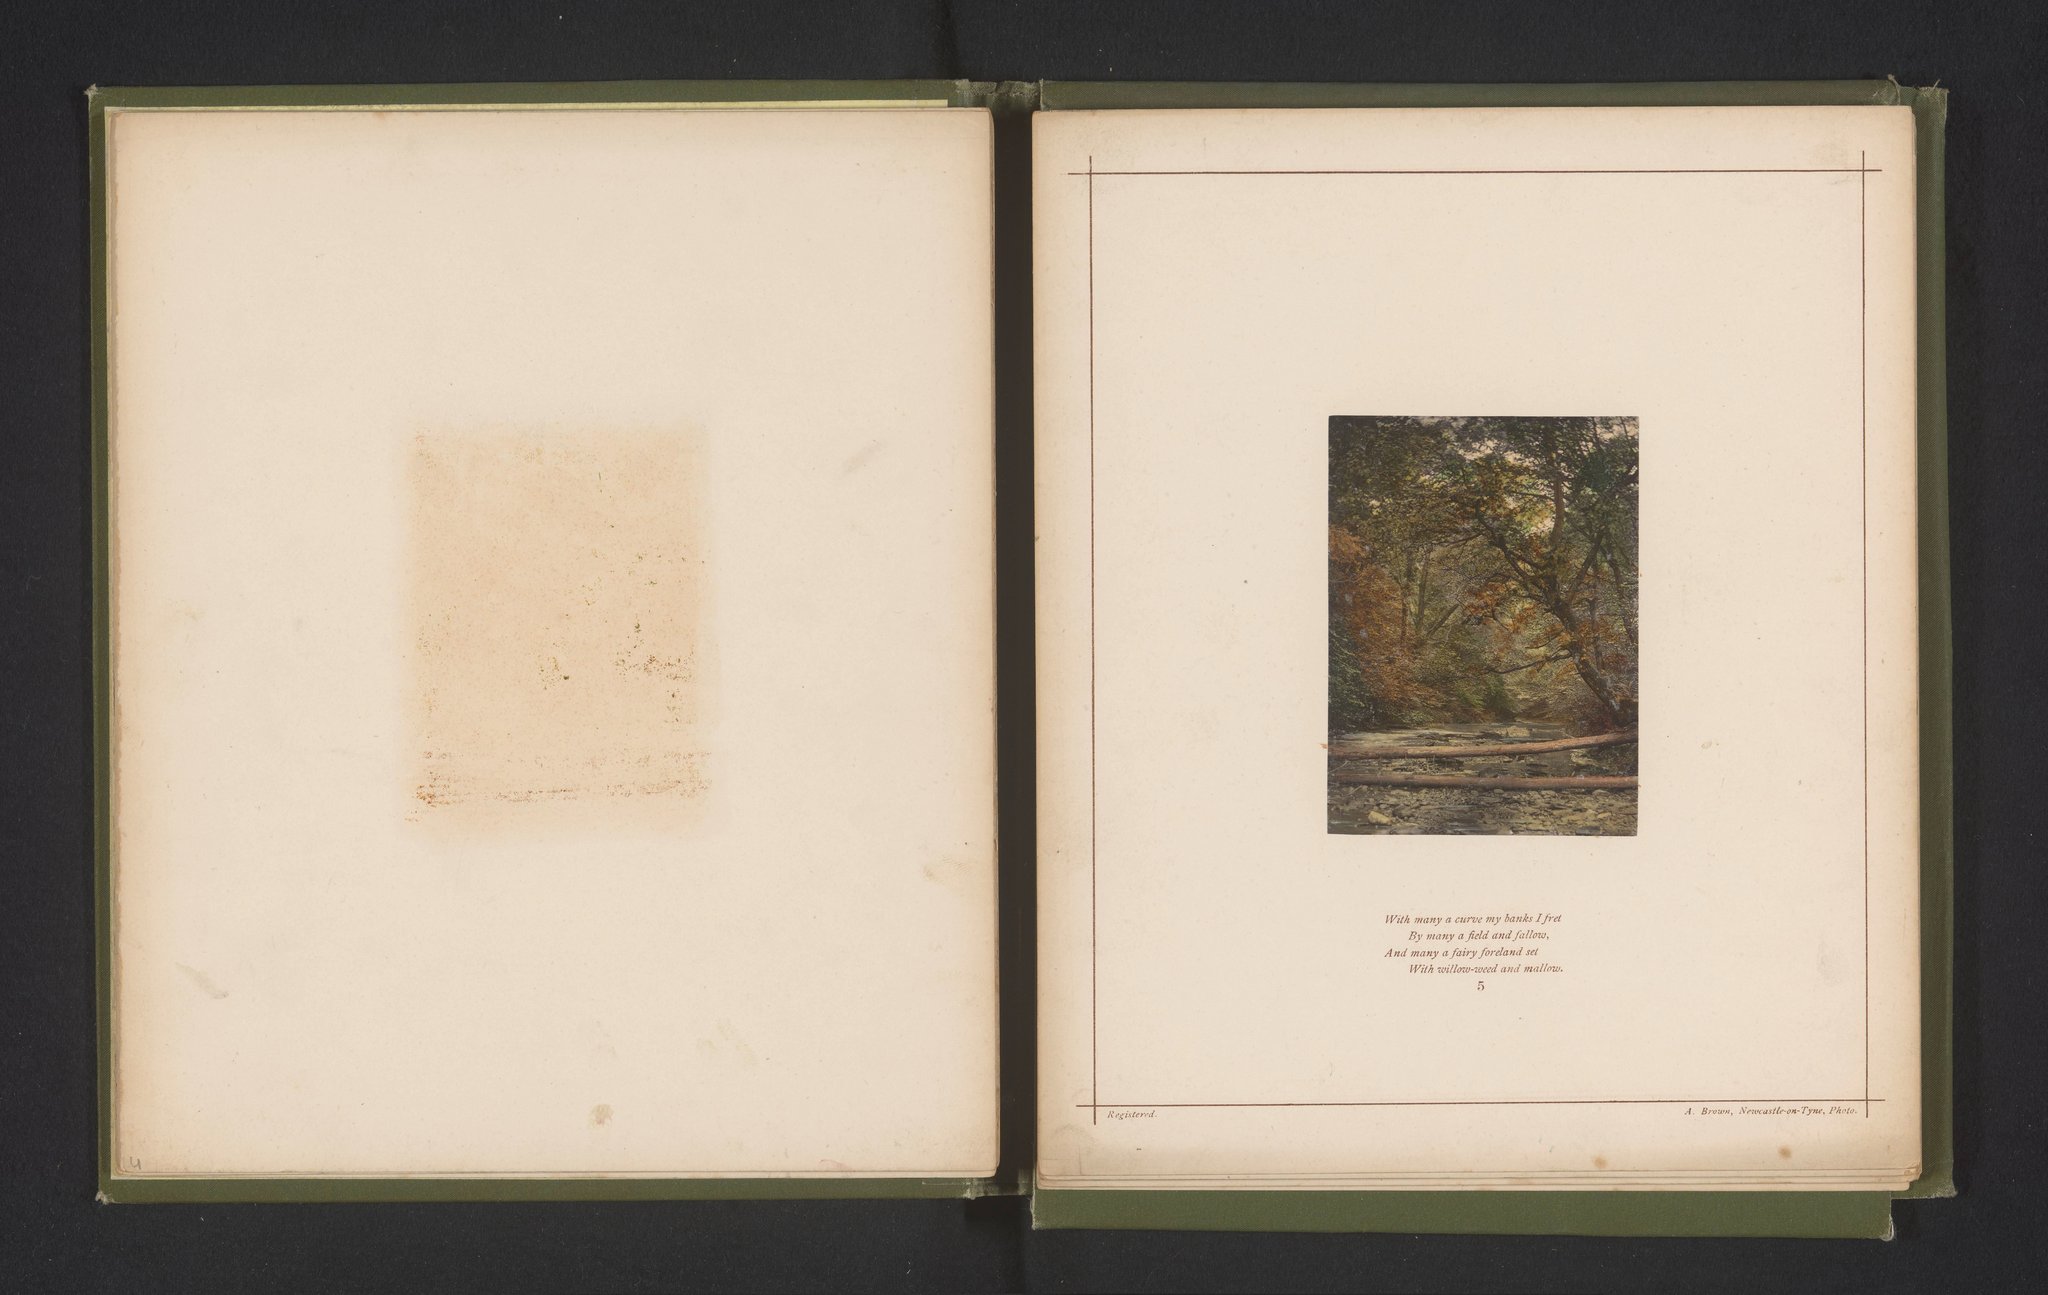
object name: photograph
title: Gezicht op de beek Skelton Beck nabij Saltburn-by-the-Sea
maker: arthur brown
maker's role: fotograaf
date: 1874-1879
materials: paper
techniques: carbon print, hand coloring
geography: north yorkshire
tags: brook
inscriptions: inscription: ‘With many a (...) and mallow.’, number: ‘5’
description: Deze foto maakt deel uit van een omslag met dertien foto's.